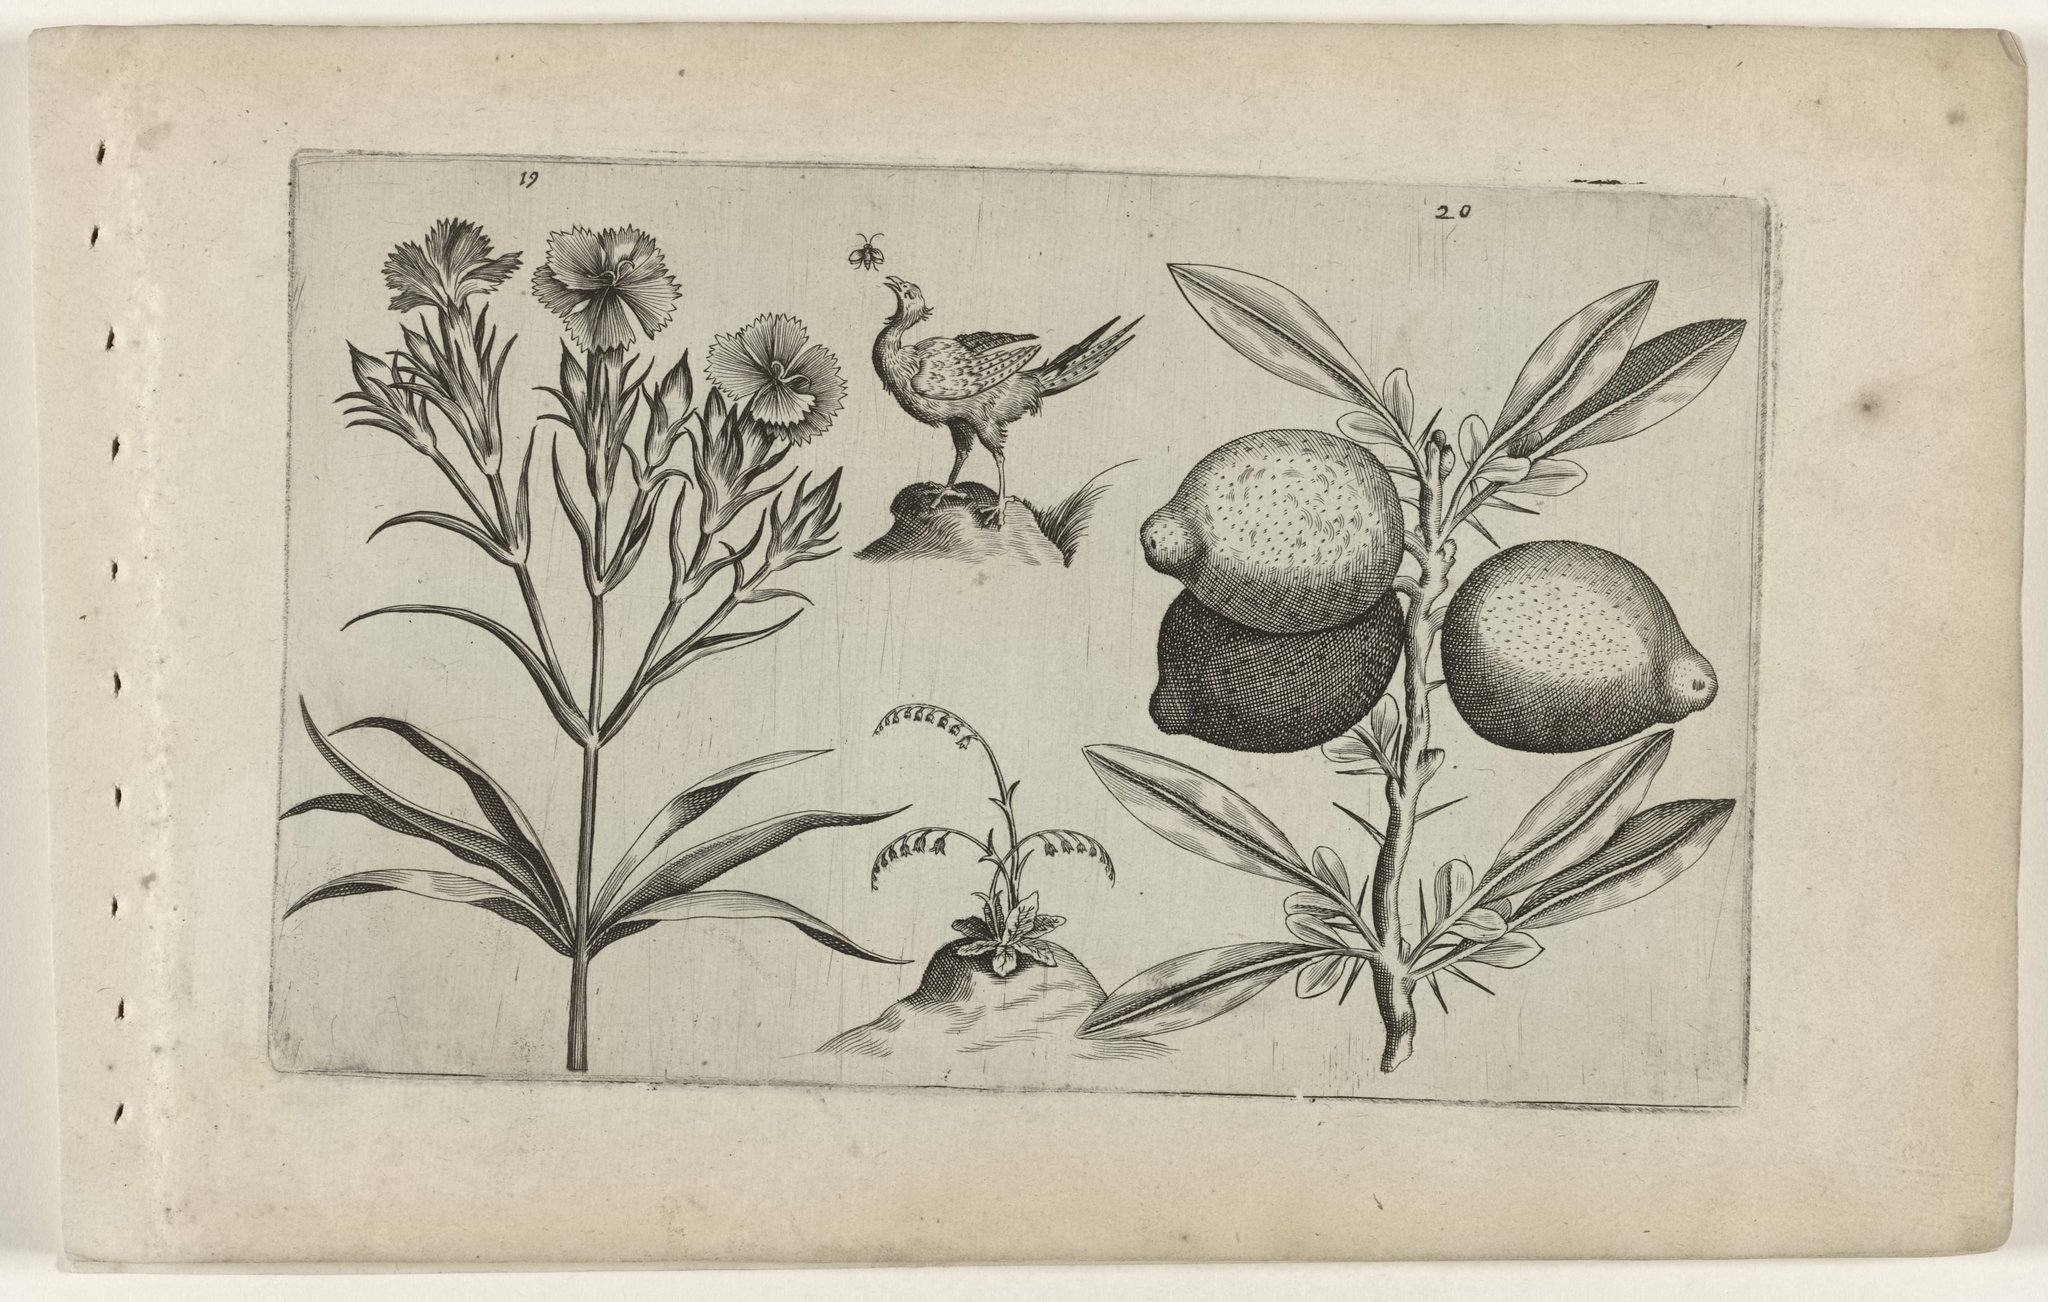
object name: print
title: Cognoscite lilia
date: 1600-1604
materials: paper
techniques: engraving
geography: cologne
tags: botany, flowers: carnation, fruits: lemon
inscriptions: collector's mark: Lugt 2228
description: De prenten RP-P-2012-24-1 t/m 61 waren oorspronkelijk als serie samengebonden. De naaigaten op de bladen zijn nog zichtbaar. Het betreft de reeks getiteld: Cognoscite lilia, bestaande uit een titelprent en 60 gravures met 119 genummerde weergaven van planten, bloemen en vruchten, versierd met rinceaux en kleine voorstellingen van dieren. Het gaat om proefdrukken van deze reeks gravures, voor de opschriften en, deels, voor de nummering. Op enkele prenten zijn de nummers met de hand aangebracht. Op de titelprent ontbreekt nog het adres van Crispijn de Passe en Hans Woutneel. De titel is hoogstwaarschijnlijk gegraveerd door Matthias Quad. Deze werkte voor De Passe in Keulen tot 1604. De reeks moet in dit jaar of daarvoor tot stand zijn gebracht. In ieder geval voor 1608, aangezien de uitgever Hans Woutneel in of voor dat jaar overleed. In ieder geval voor 1608, aangezien de uitgever Hans Woutneel in of voor dat jaar overleed. De gravures worden door Ilja Veldman en Anthony Griffiths beschouwd als eigenhandig werk van Crispijn de Passe I. Een van de prenten uit de reeks ontbreekt (nr 21-22) en is vervangen door een ingekleurde afdruk uit een latere uitgave (RP-P-2012-24-61), die onder de titel Altera Pars is opgenomen in de Hortus Floridus, uitgegeven door Crispijn de Passe I en die verder bestaat uit platen van Crispijn de Passe II. De prenten afkomstig uit deze uitgave zijn op de verso voorzien van tekst in boekdruk. De vervangende prent maakte geen deel uit van de gebonden serie aangezien dit blad als enige geen naaigaten heeft. Een deel van de planten, bloemen en vruchten in de Cognoscite lilia gaat terug of is gebaseerd op een reeks aquarellen van Jacques LeMoyne uit circa 1580 en uit 1585, nu in het Victoria and Albert Museum en de British Museum (zie P. Hulton, Jacques LeMoyne, Londen 1977, dl 1, p. 156-162 en p. 165-173).